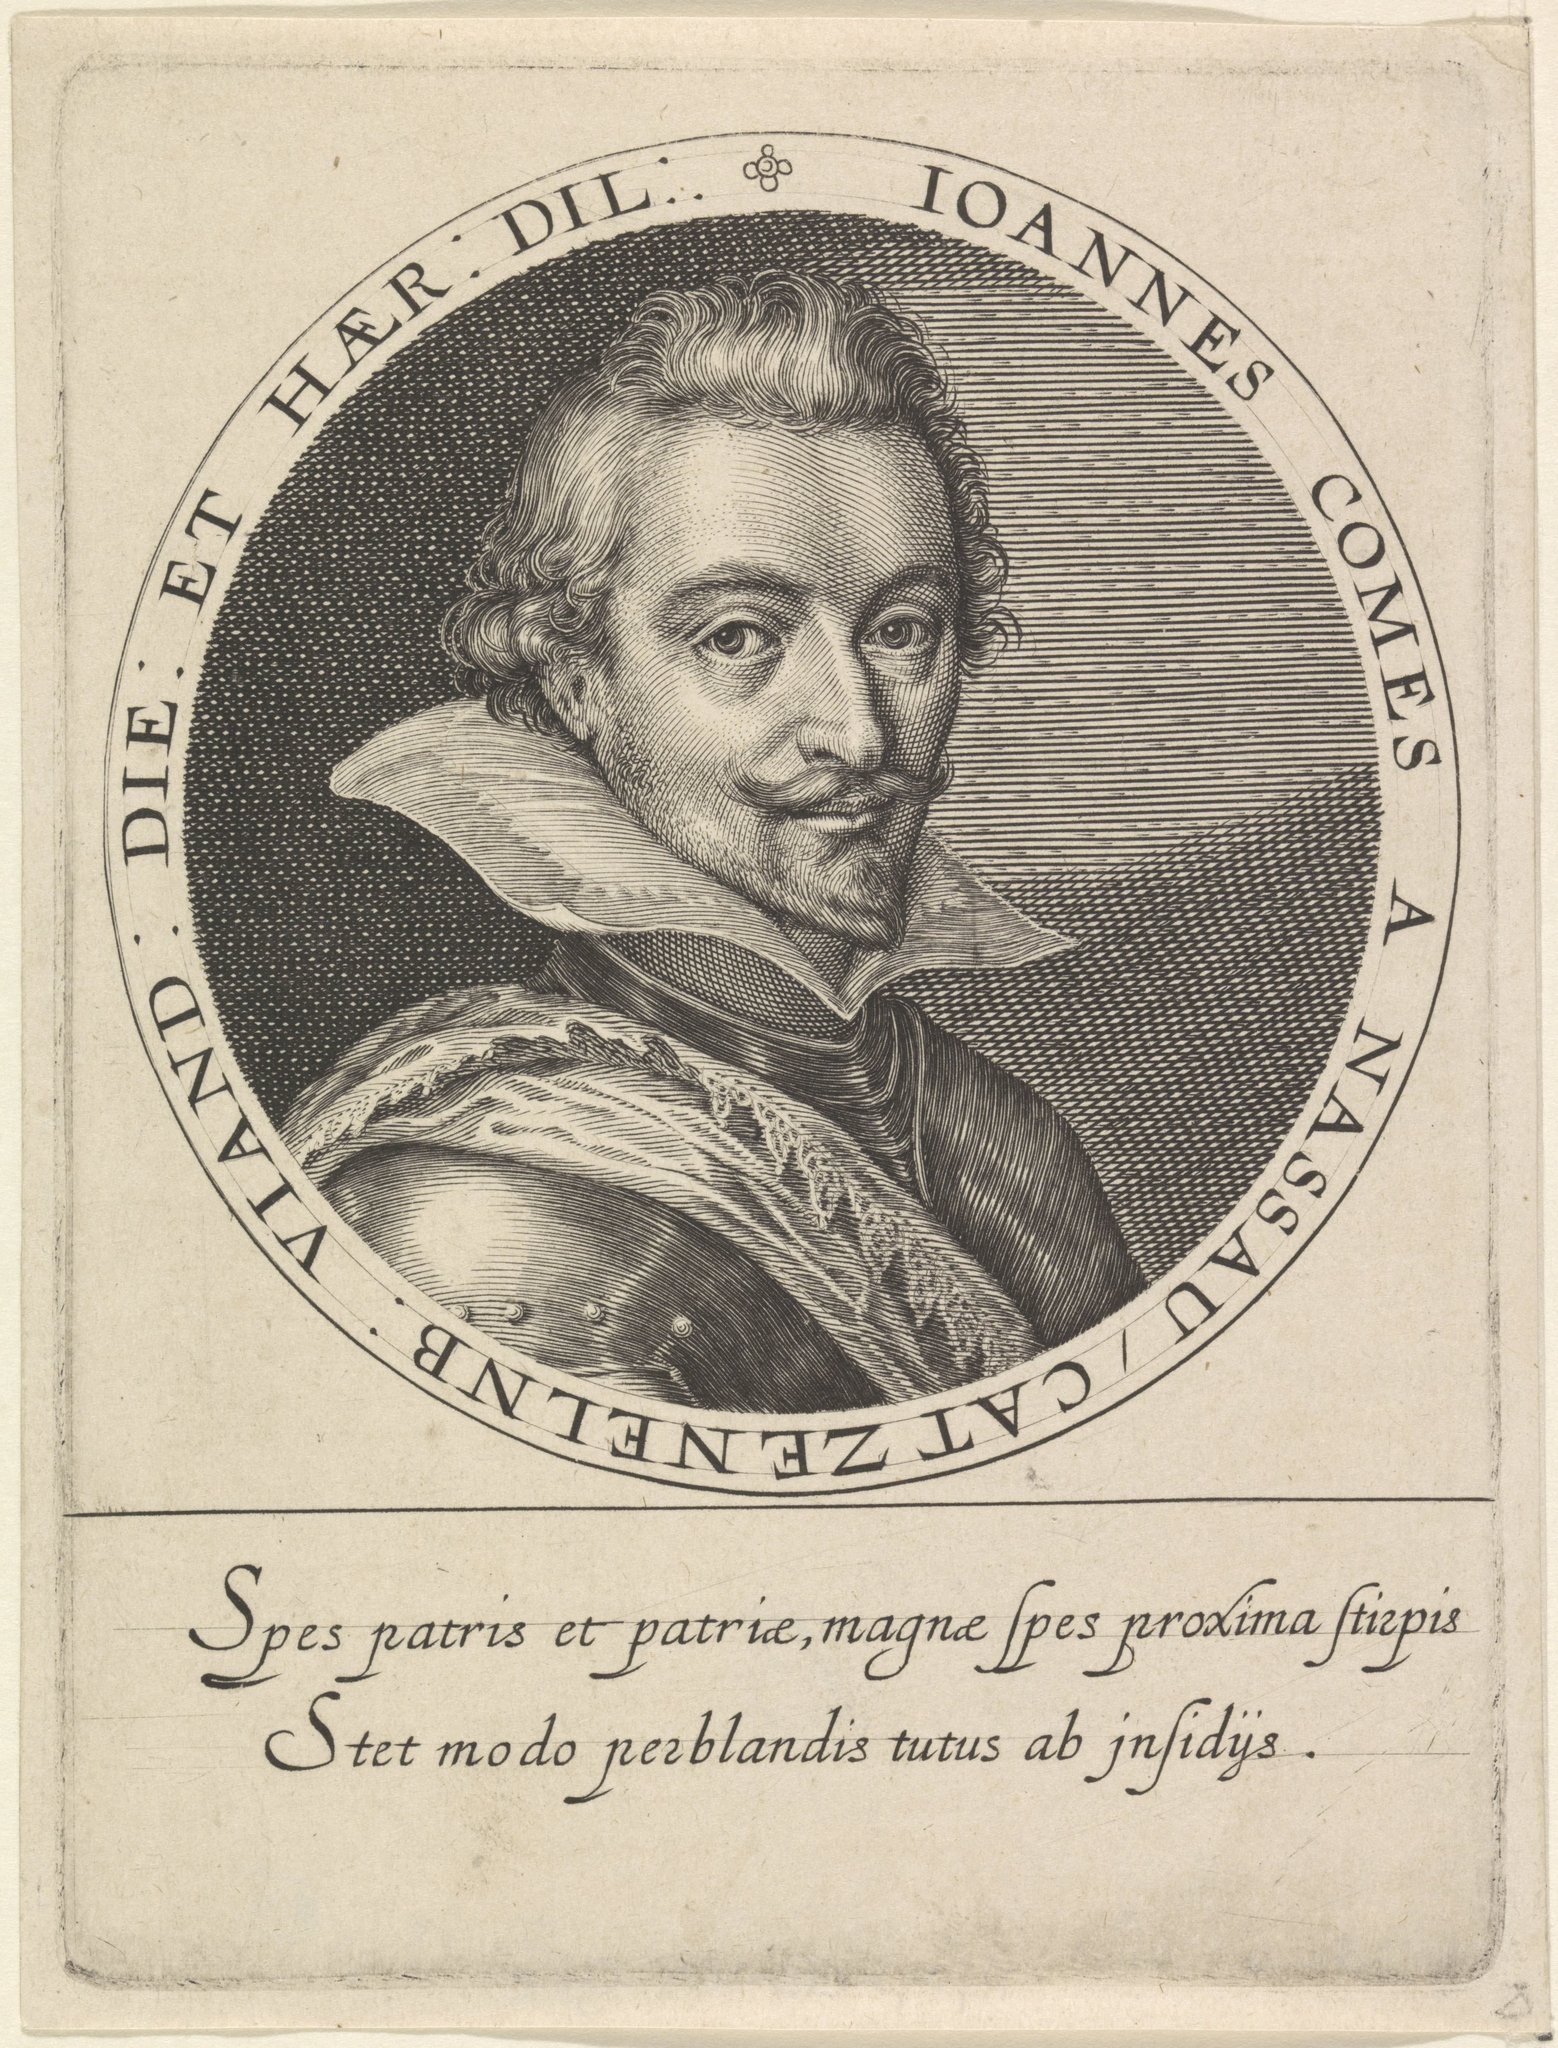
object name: book illustration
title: Portret van Johan VIII, graaf van Nassau-Siegen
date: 1615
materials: paper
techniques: engraving, etching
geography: utrecht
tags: dillenburg, renaix, johan viii graaf van nassau-siegen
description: De hier vermelde titel verwijst naar de hoogst verkregen titel van de geportretteerde, niet per se naar de titel die de geportretteerde op deze voorstelling draagt. Prent uit: Buchelius, Arnoldus. Nassovischen Oraignen-boom, daer by ghevoecht, de conterfeytsels der voornaemster helden. = Malus Aurantius Nassovicus. Utrecht: Salomon de Roy, 1615.